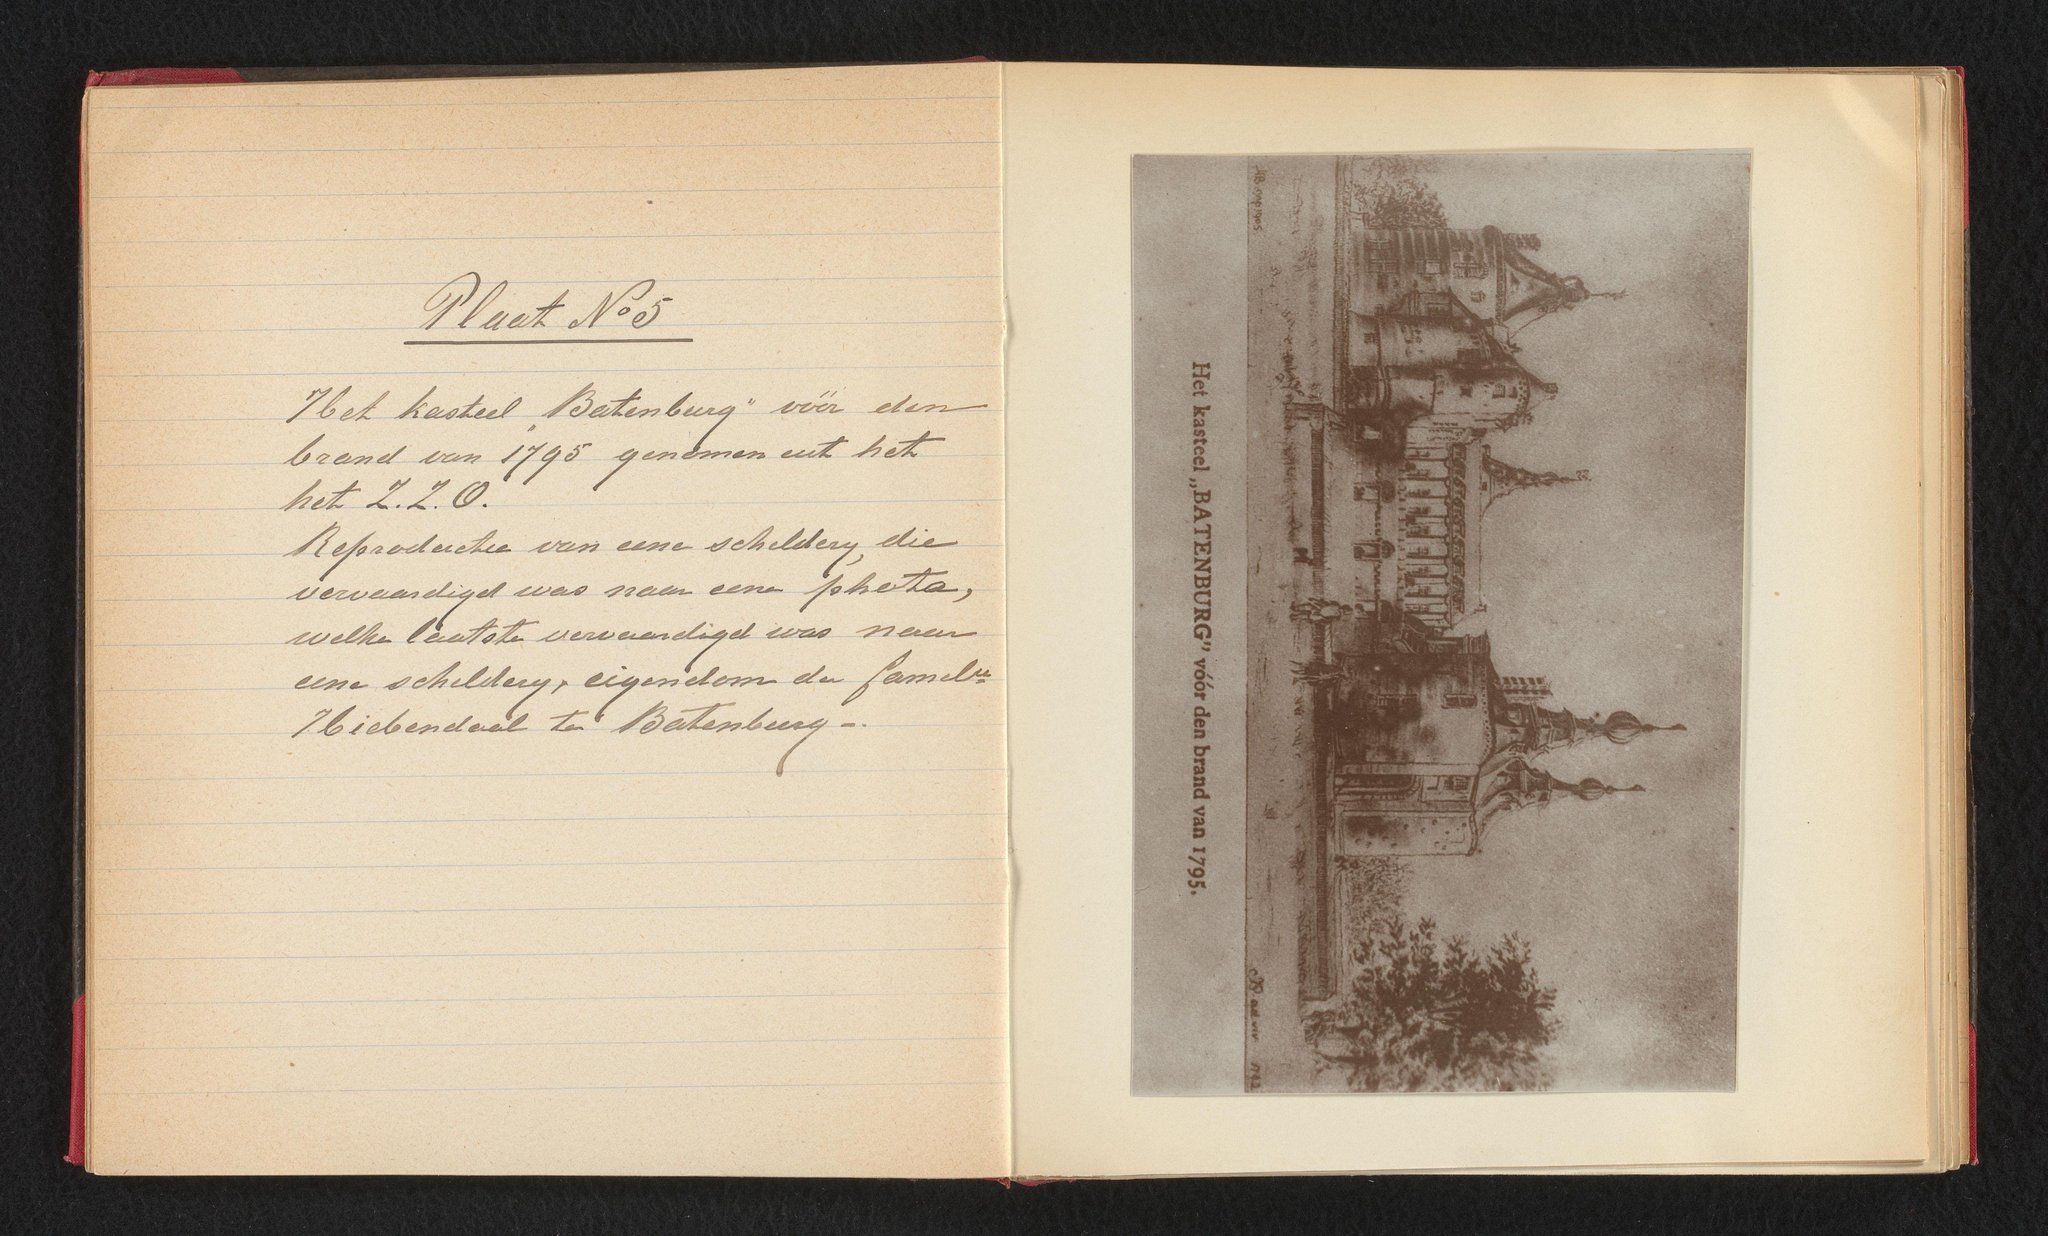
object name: page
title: Het Kasteel "Batenburg" vóór den brand van 1795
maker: benjamin charlé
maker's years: 1845-1925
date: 1902-1907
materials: paper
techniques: collodion silver print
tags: castle